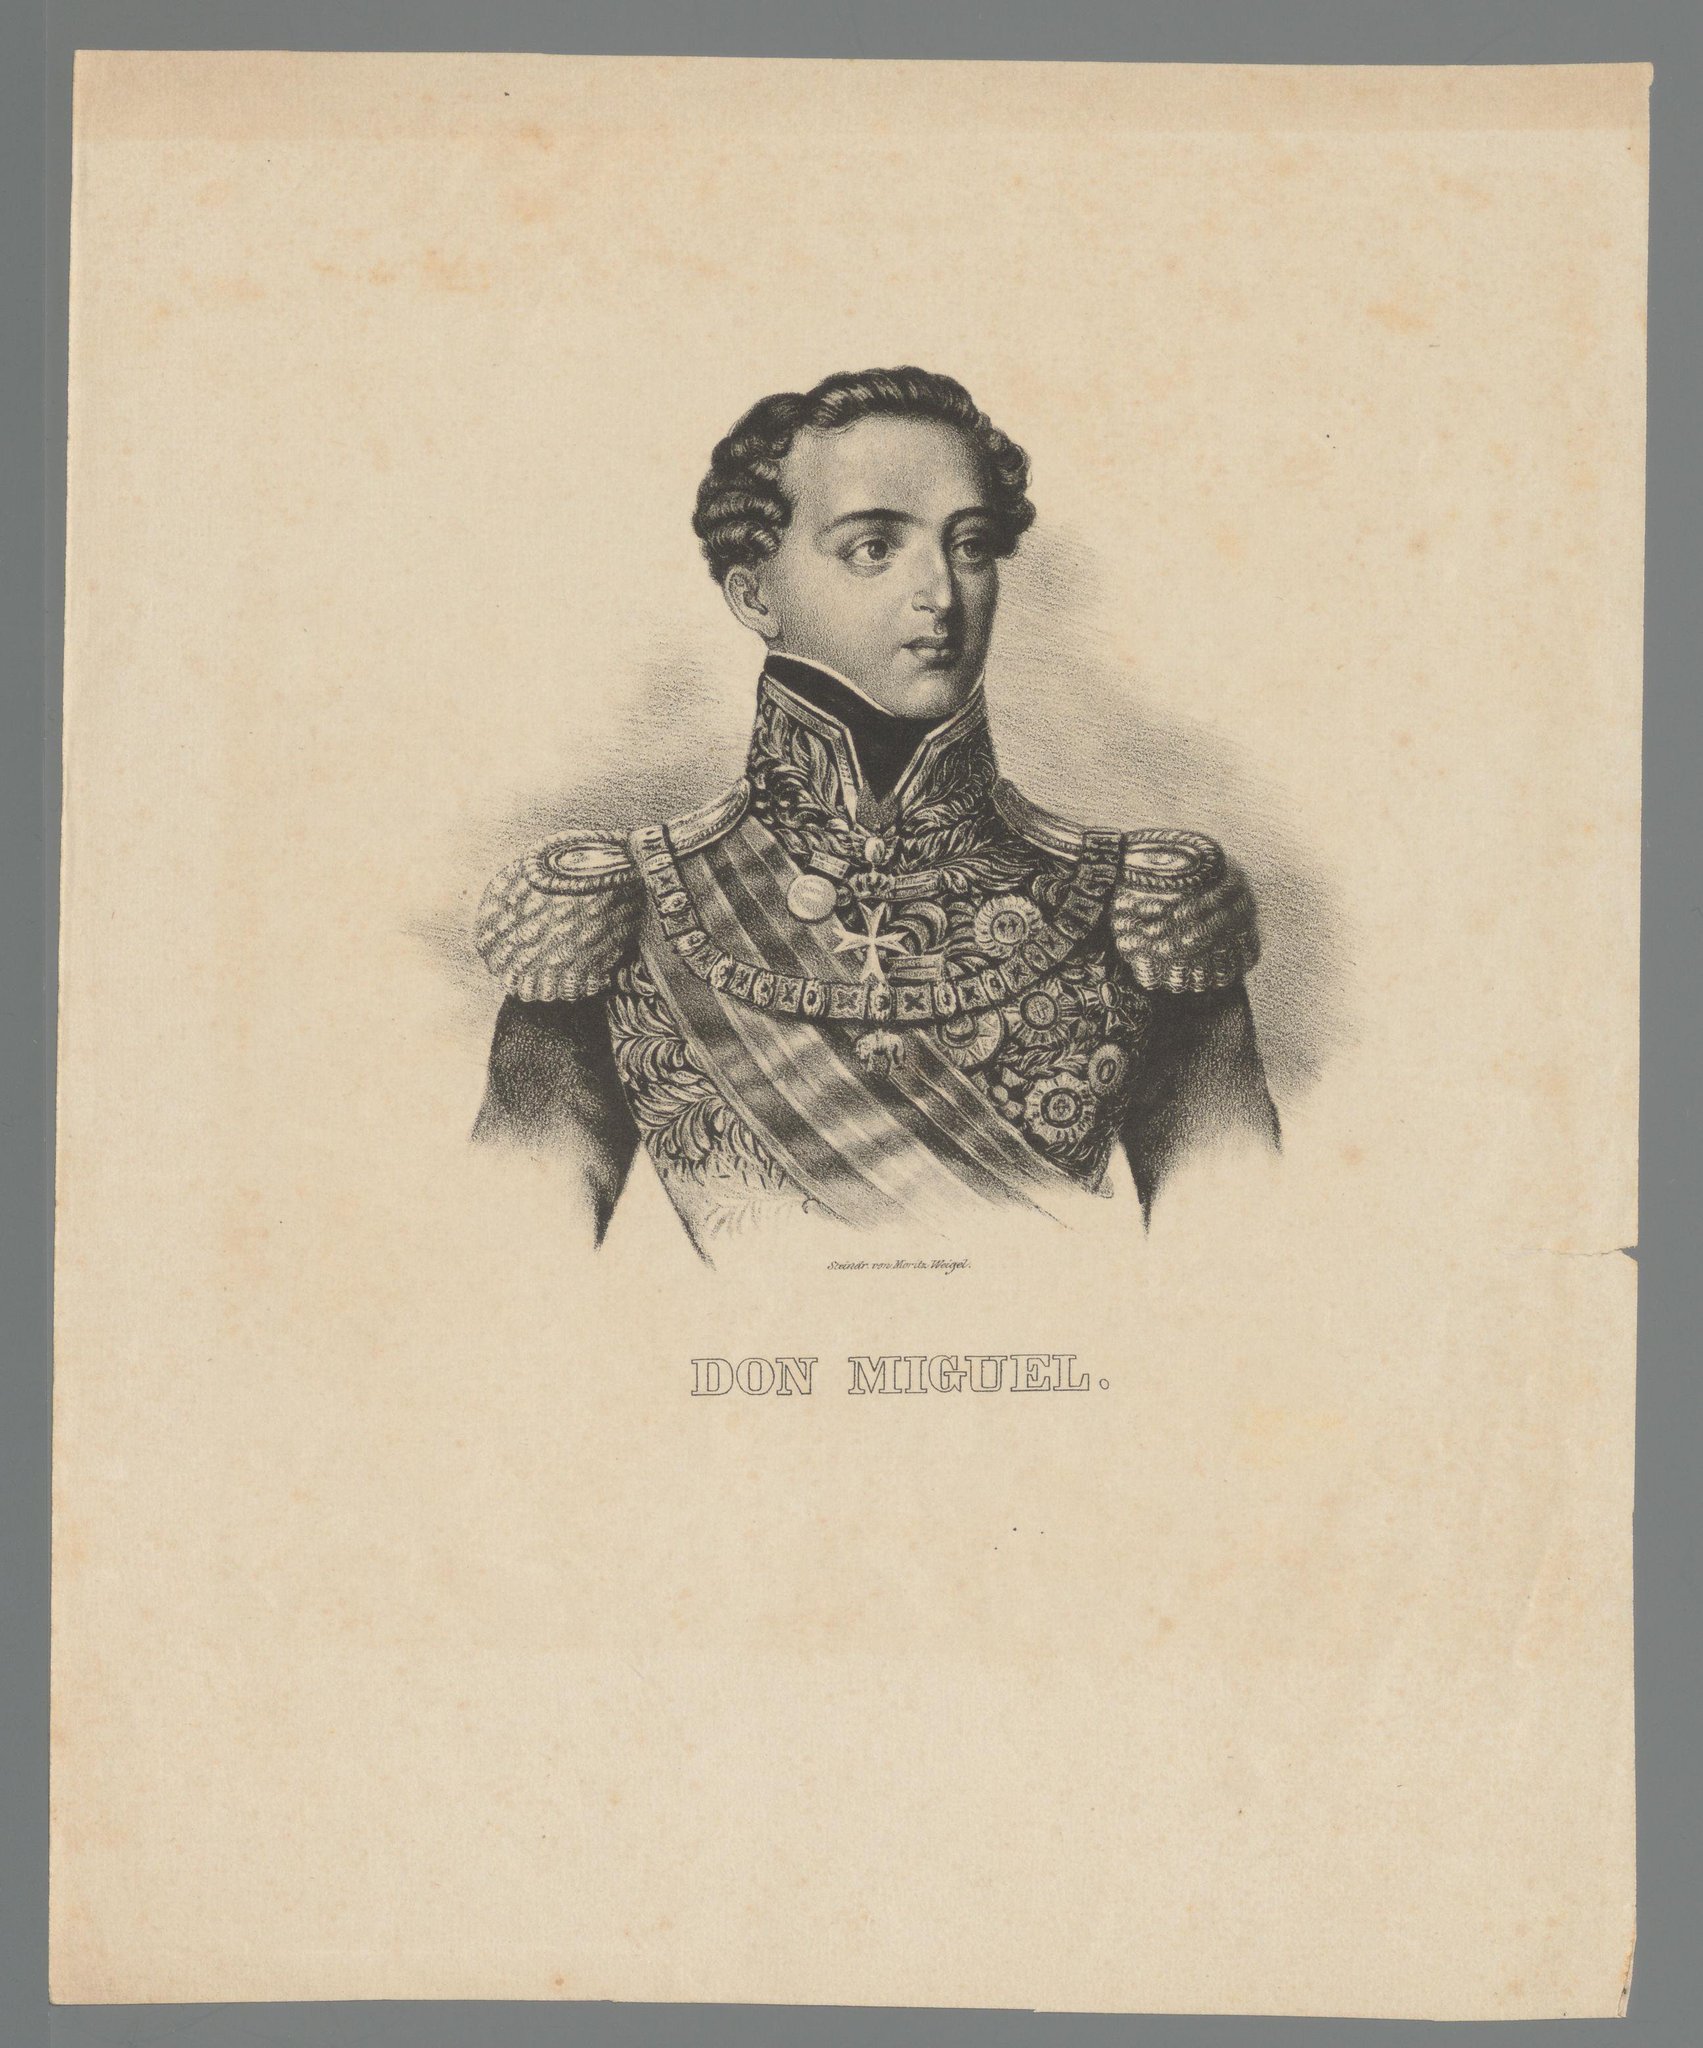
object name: print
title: Portret van Don Miguel, koning van Portugal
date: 1820-1870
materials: paper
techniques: lithograph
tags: adult man, historical persons, knighthood order of the golden fleece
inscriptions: collector's mark: Lugt 2228